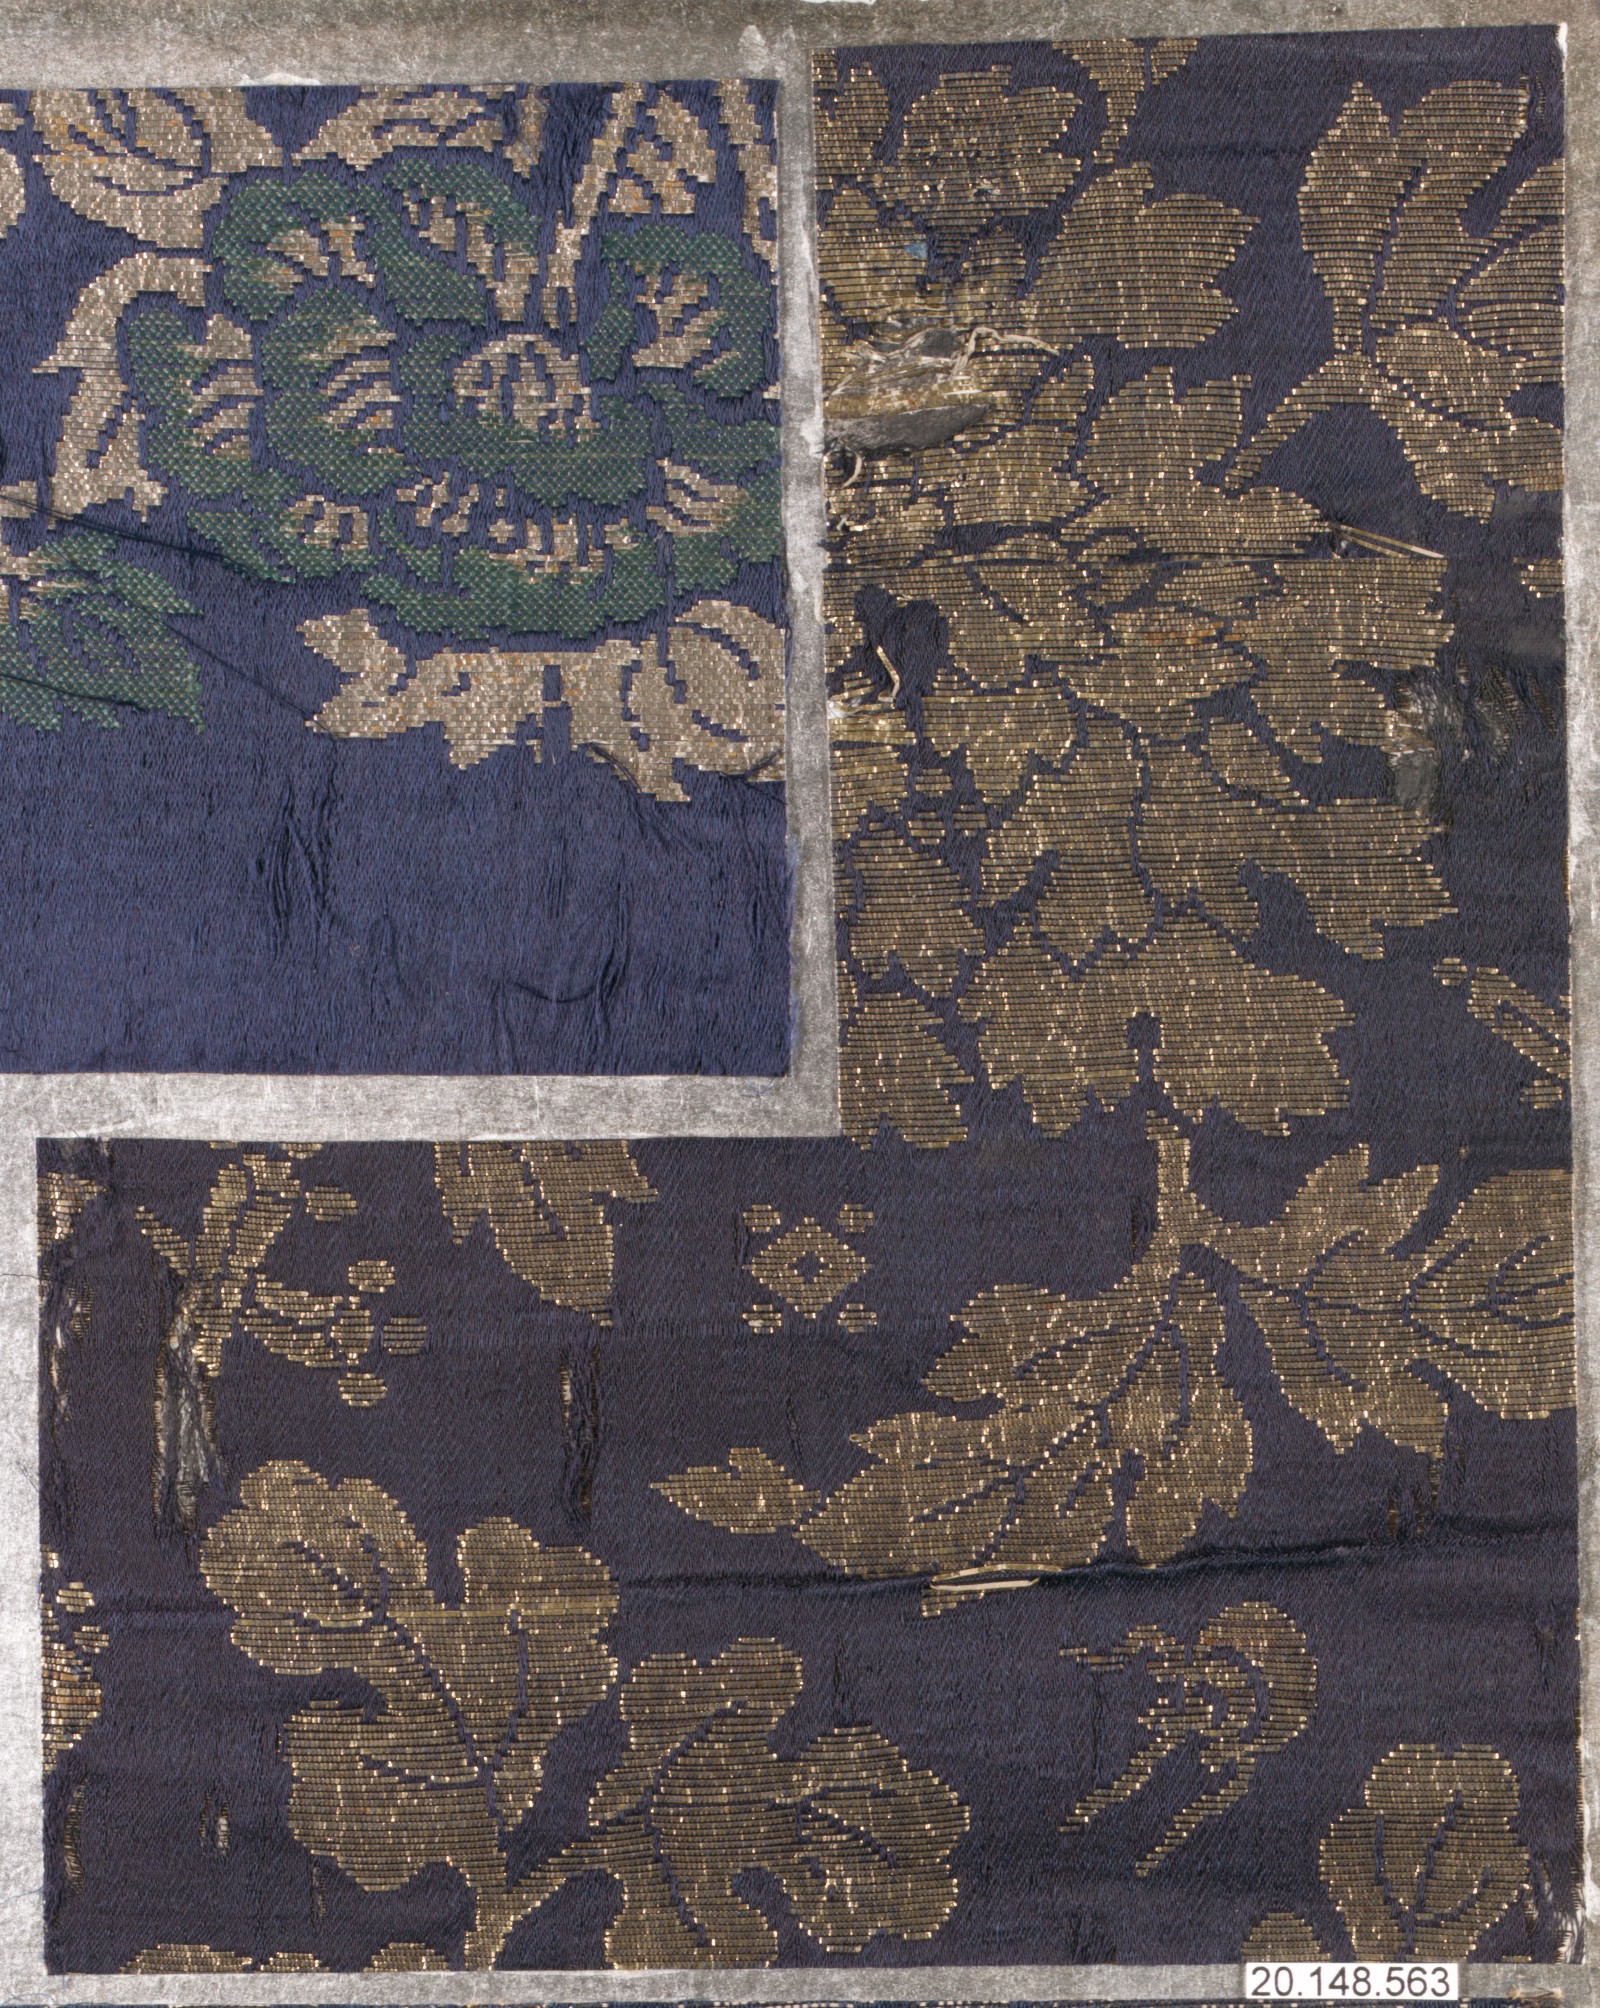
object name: piece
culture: japanese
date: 1701-1800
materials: silk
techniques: compound weave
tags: flowers,leaves